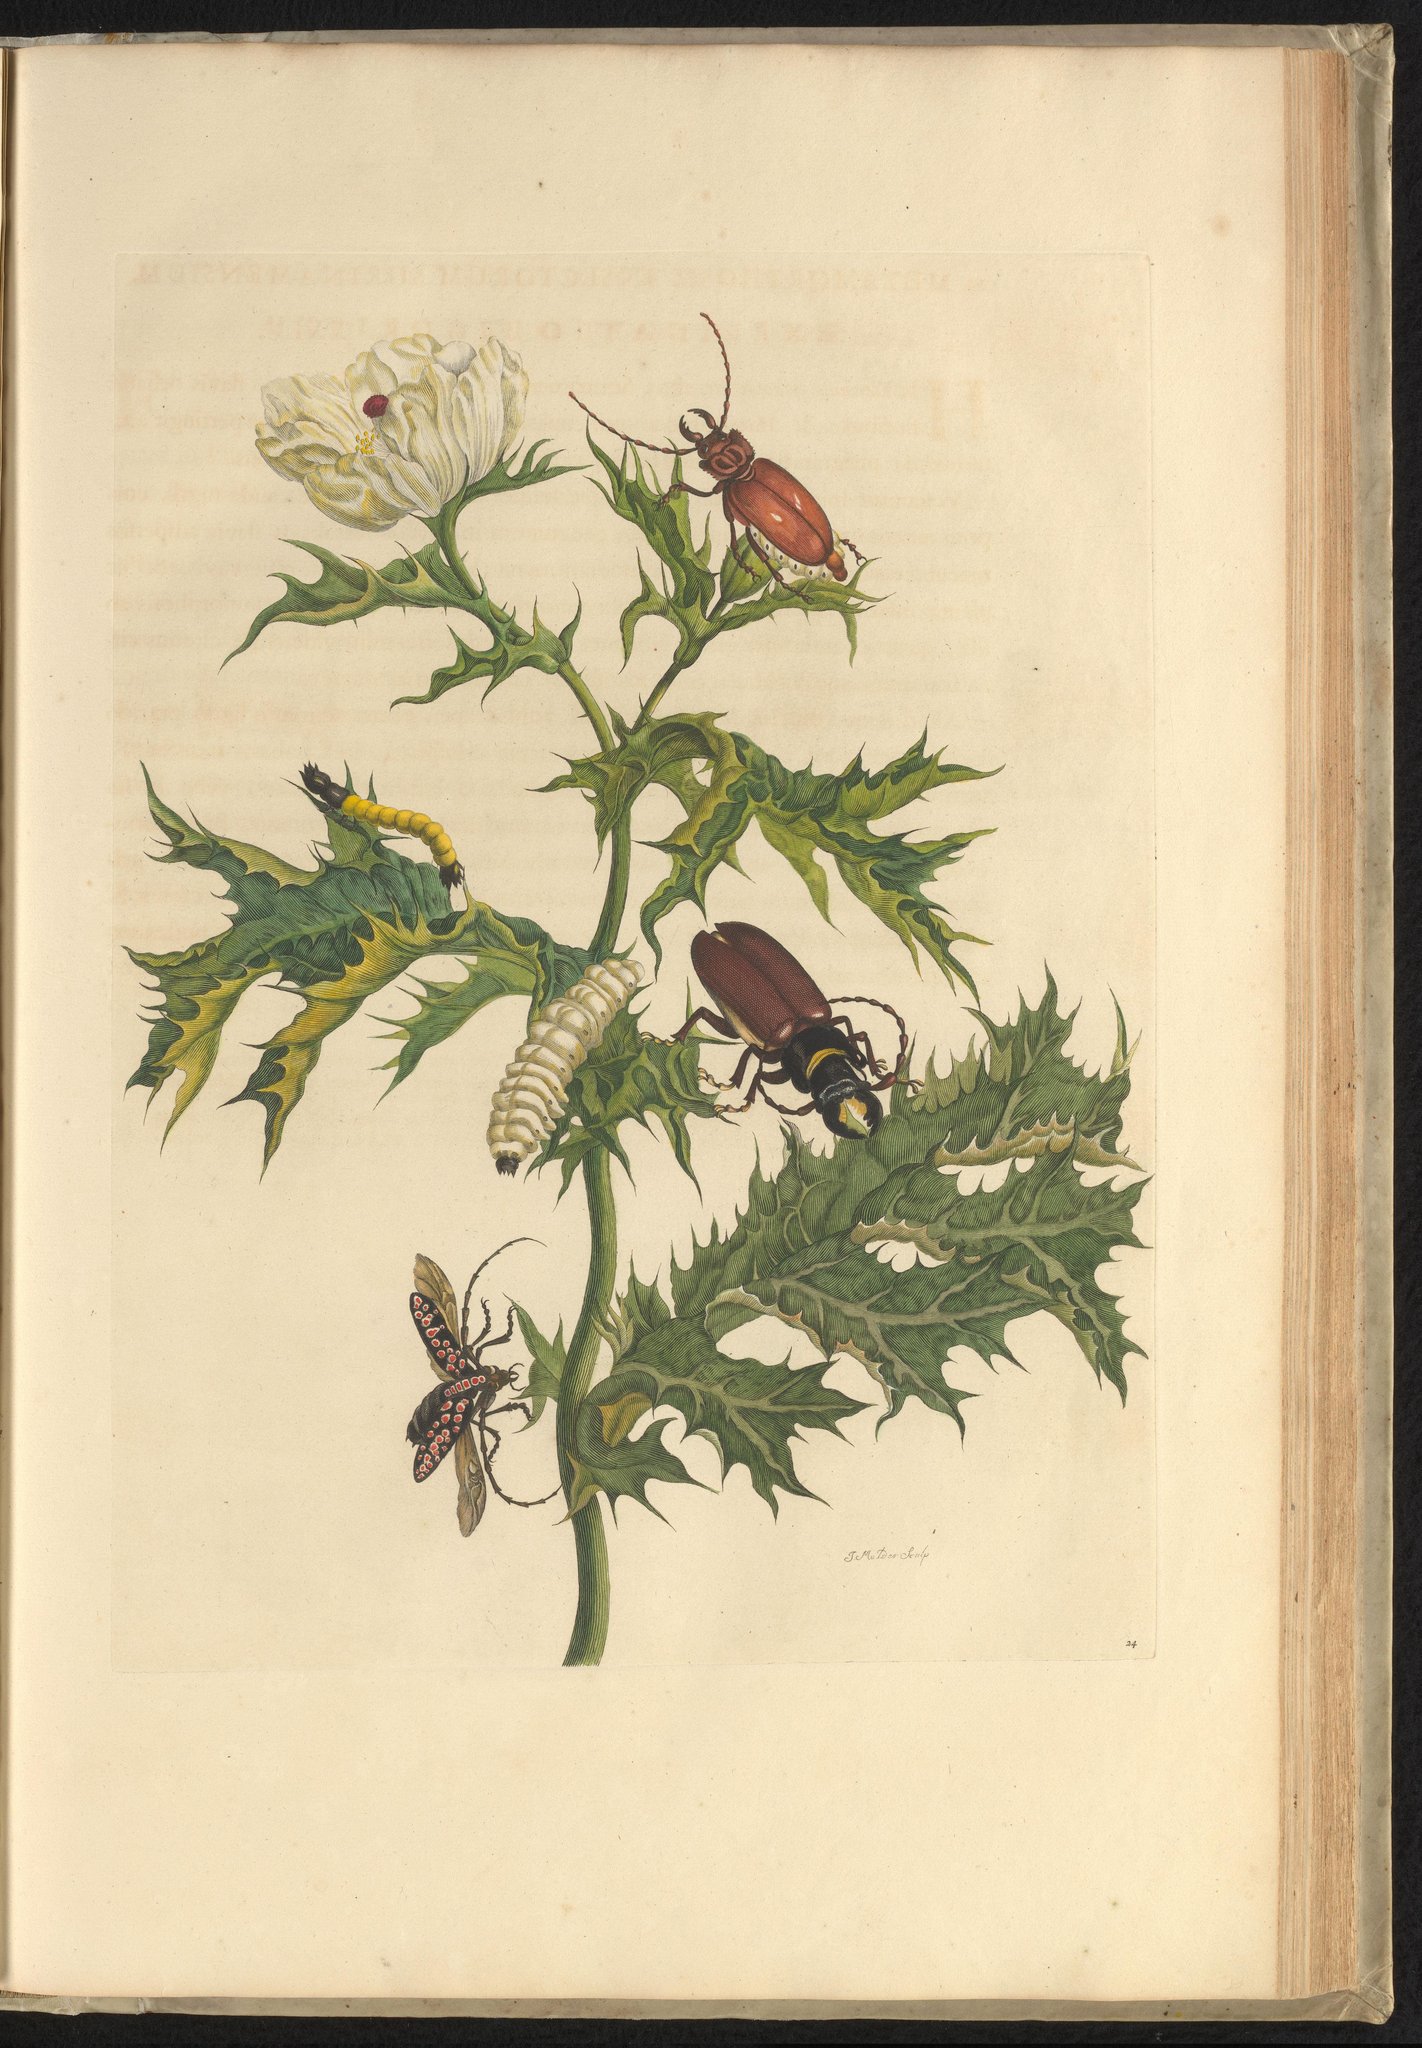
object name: print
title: Mexicaanse papaver (Argemone mexicana) met kevers en larven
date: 1705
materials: paper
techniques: etching, hand coloring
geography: amsterdam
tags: insects, flowers: poppy, insects: beetle, suriname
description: Rechtsonder genummerd: 24. Prent maakt deel uit van een boek.